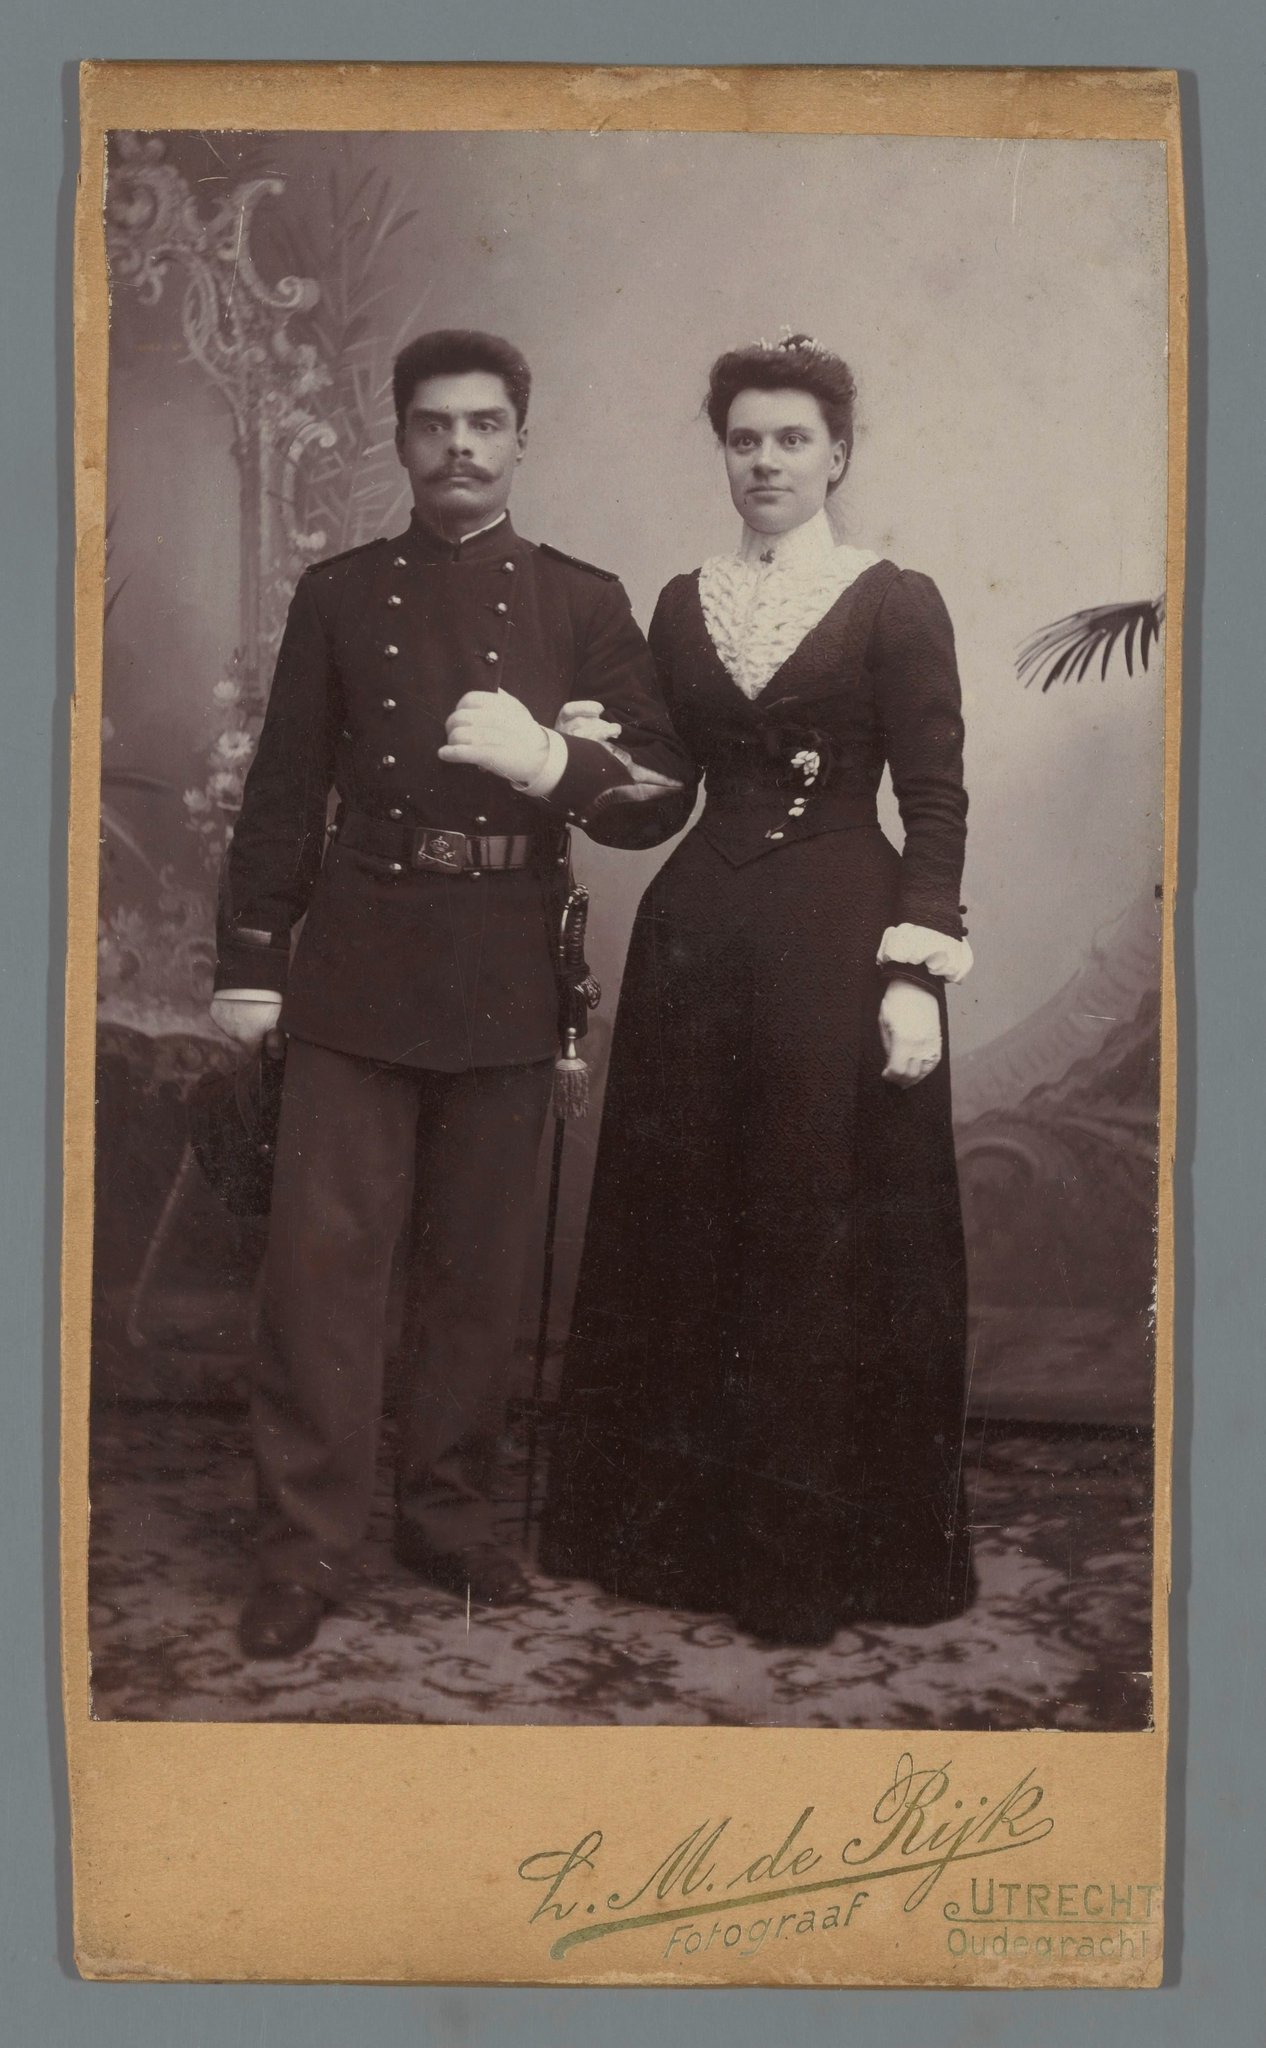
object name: cabinet photograph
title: Dubbelportret van een militair met zijn vrouw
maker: l.m. de rijk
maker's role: fotograaf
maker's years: 1869-1936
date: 1890-1900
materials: cardboard, photographic support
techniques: collodion silver print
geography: utrecht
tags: hacking and thrusting weapons, private soldier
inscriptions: : ‘Utrecht, Oudegracht 96’